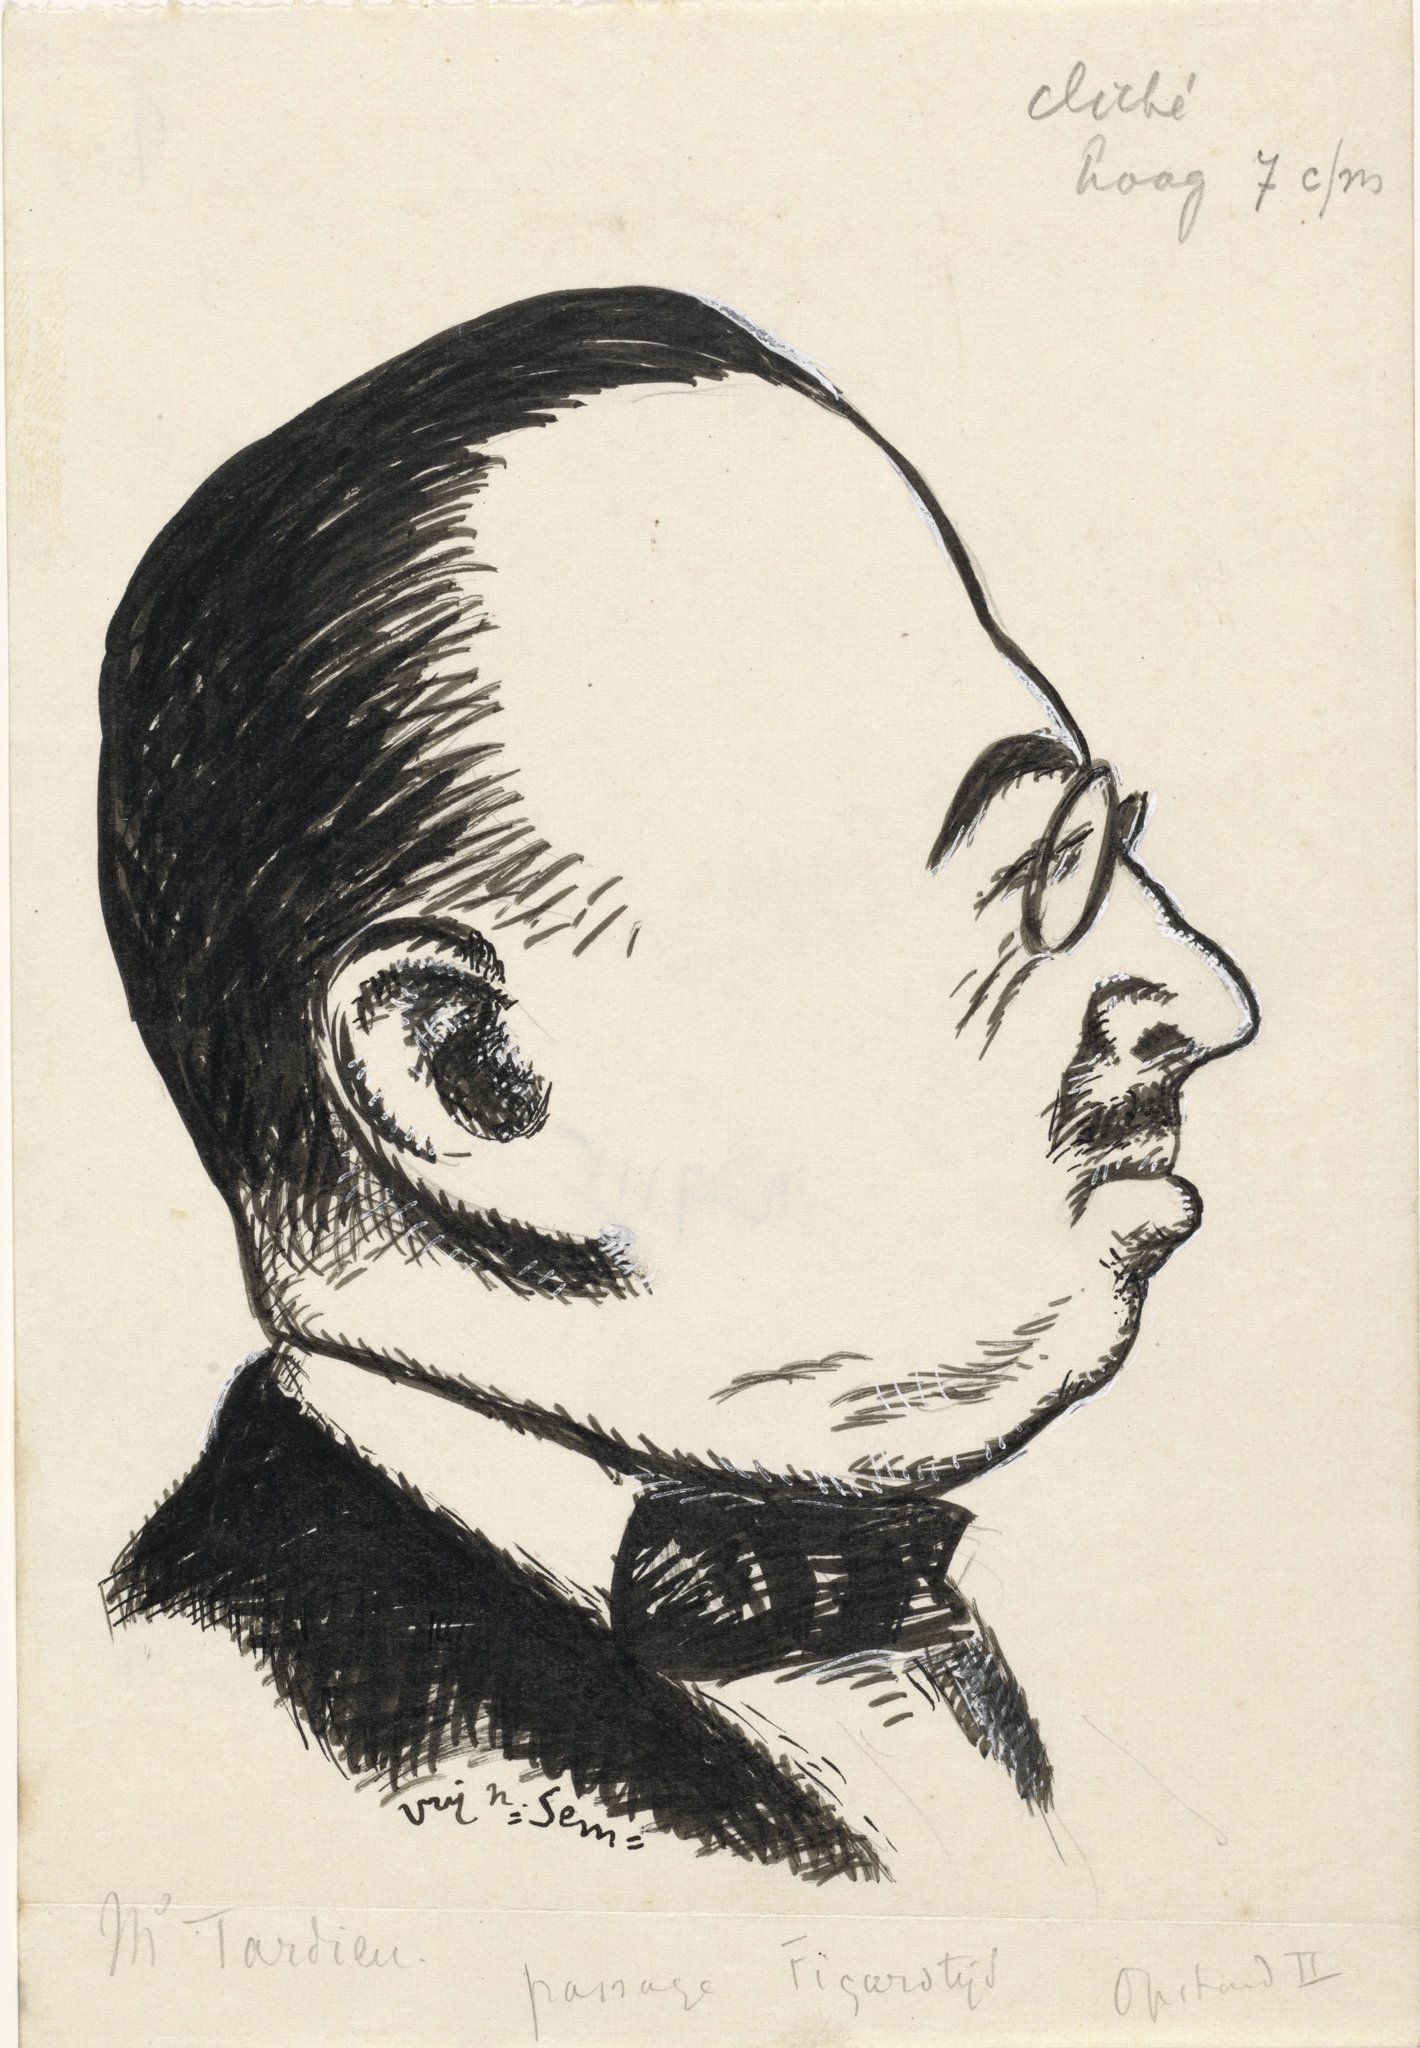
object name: boekillustratie ontwerp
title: Portret van André Tardieu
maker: leo gestel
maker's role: draughtsman, print maker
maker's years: 1881-1941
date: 1934-1936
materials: paint, ink, paper, pencil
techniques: brush, pen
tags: (cohen, van anarchist tot monarchist) specific works of literature (with author, title), historical persons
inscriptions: clichéaanwijzing, recto, handgeschreven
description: Ontwerp voor een boekillustratie voor: Cohen, Alexander. Van anarchist tot monarchist. Amsterdam: De Steenuil, 1936.